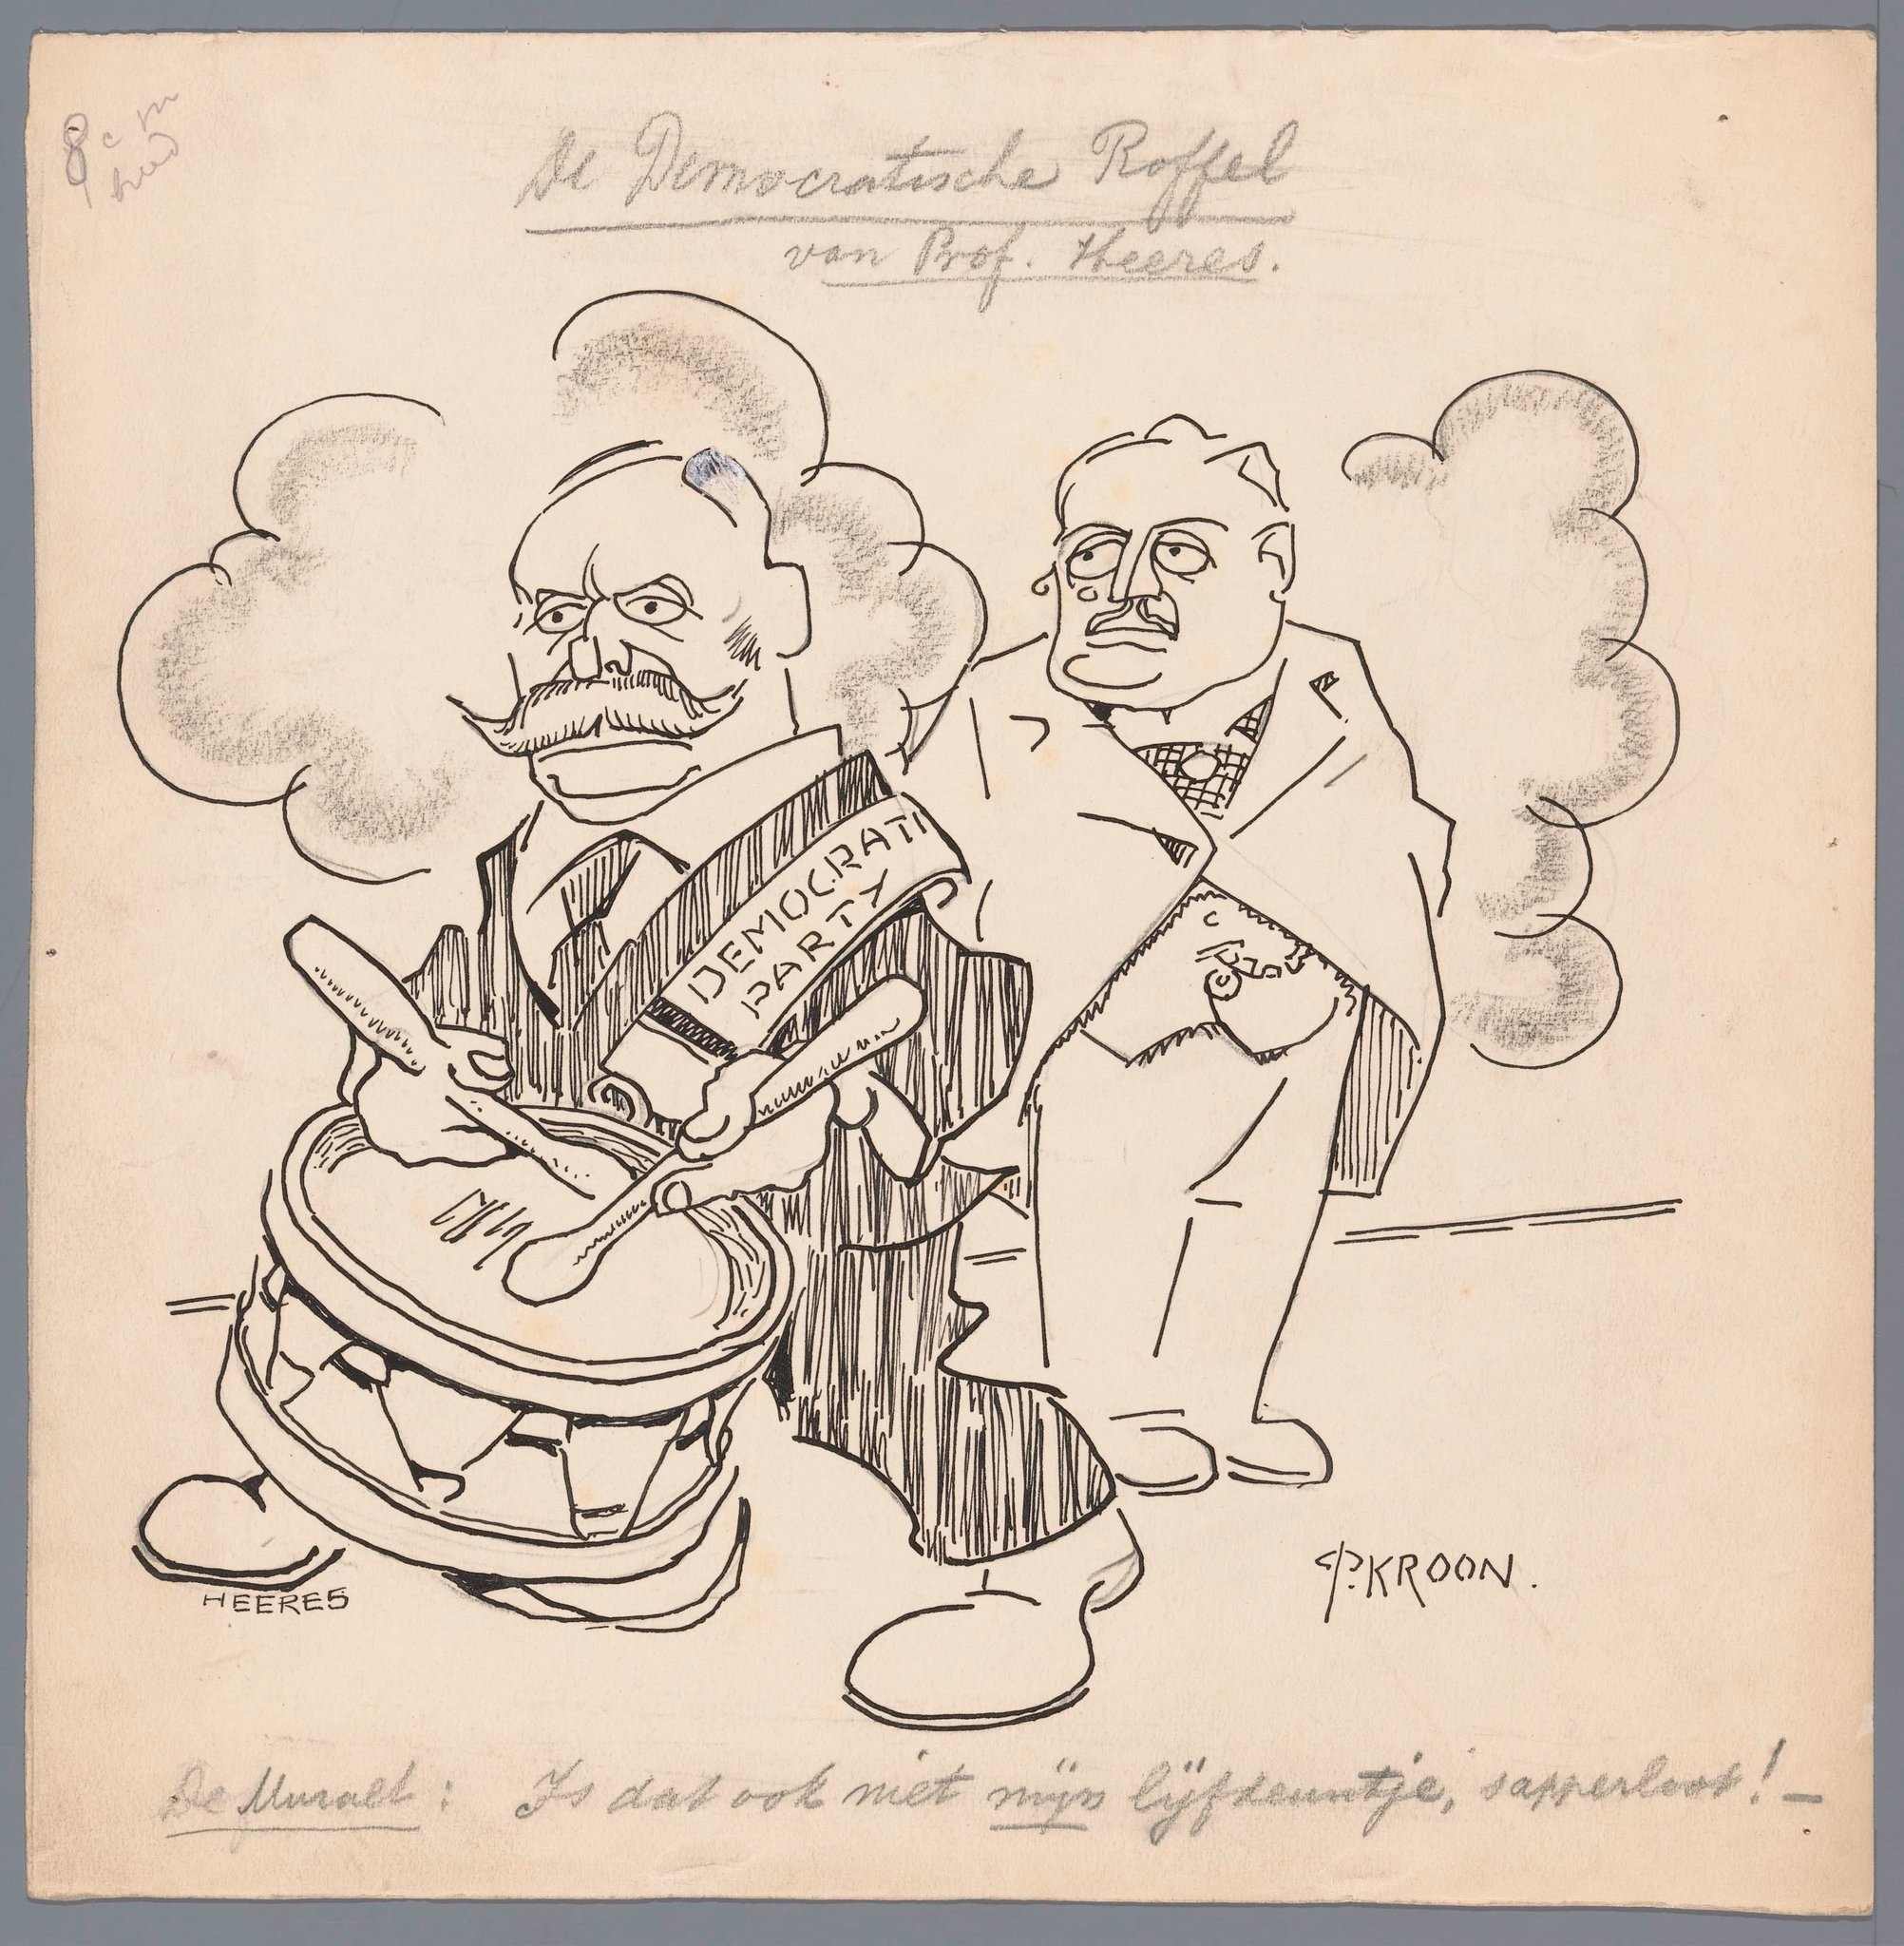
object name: drawing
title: De Democratische Roffel van Prof. Heeres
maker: patricq kroon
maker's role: draughtsman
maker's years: 1862-1941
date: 1921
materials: paper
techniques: pen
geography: netherlands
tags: political parties, political caricatures and satires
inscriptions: number: ‘16963’, inscription: ‘De Democratische Roffel van Prof. Heeres’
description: J.E. Heeres slaat op de trommel, op de riem van de trommel staat: Democratische Partij (opgericht in 1921). Ontwerp voor een politieke spotprent.